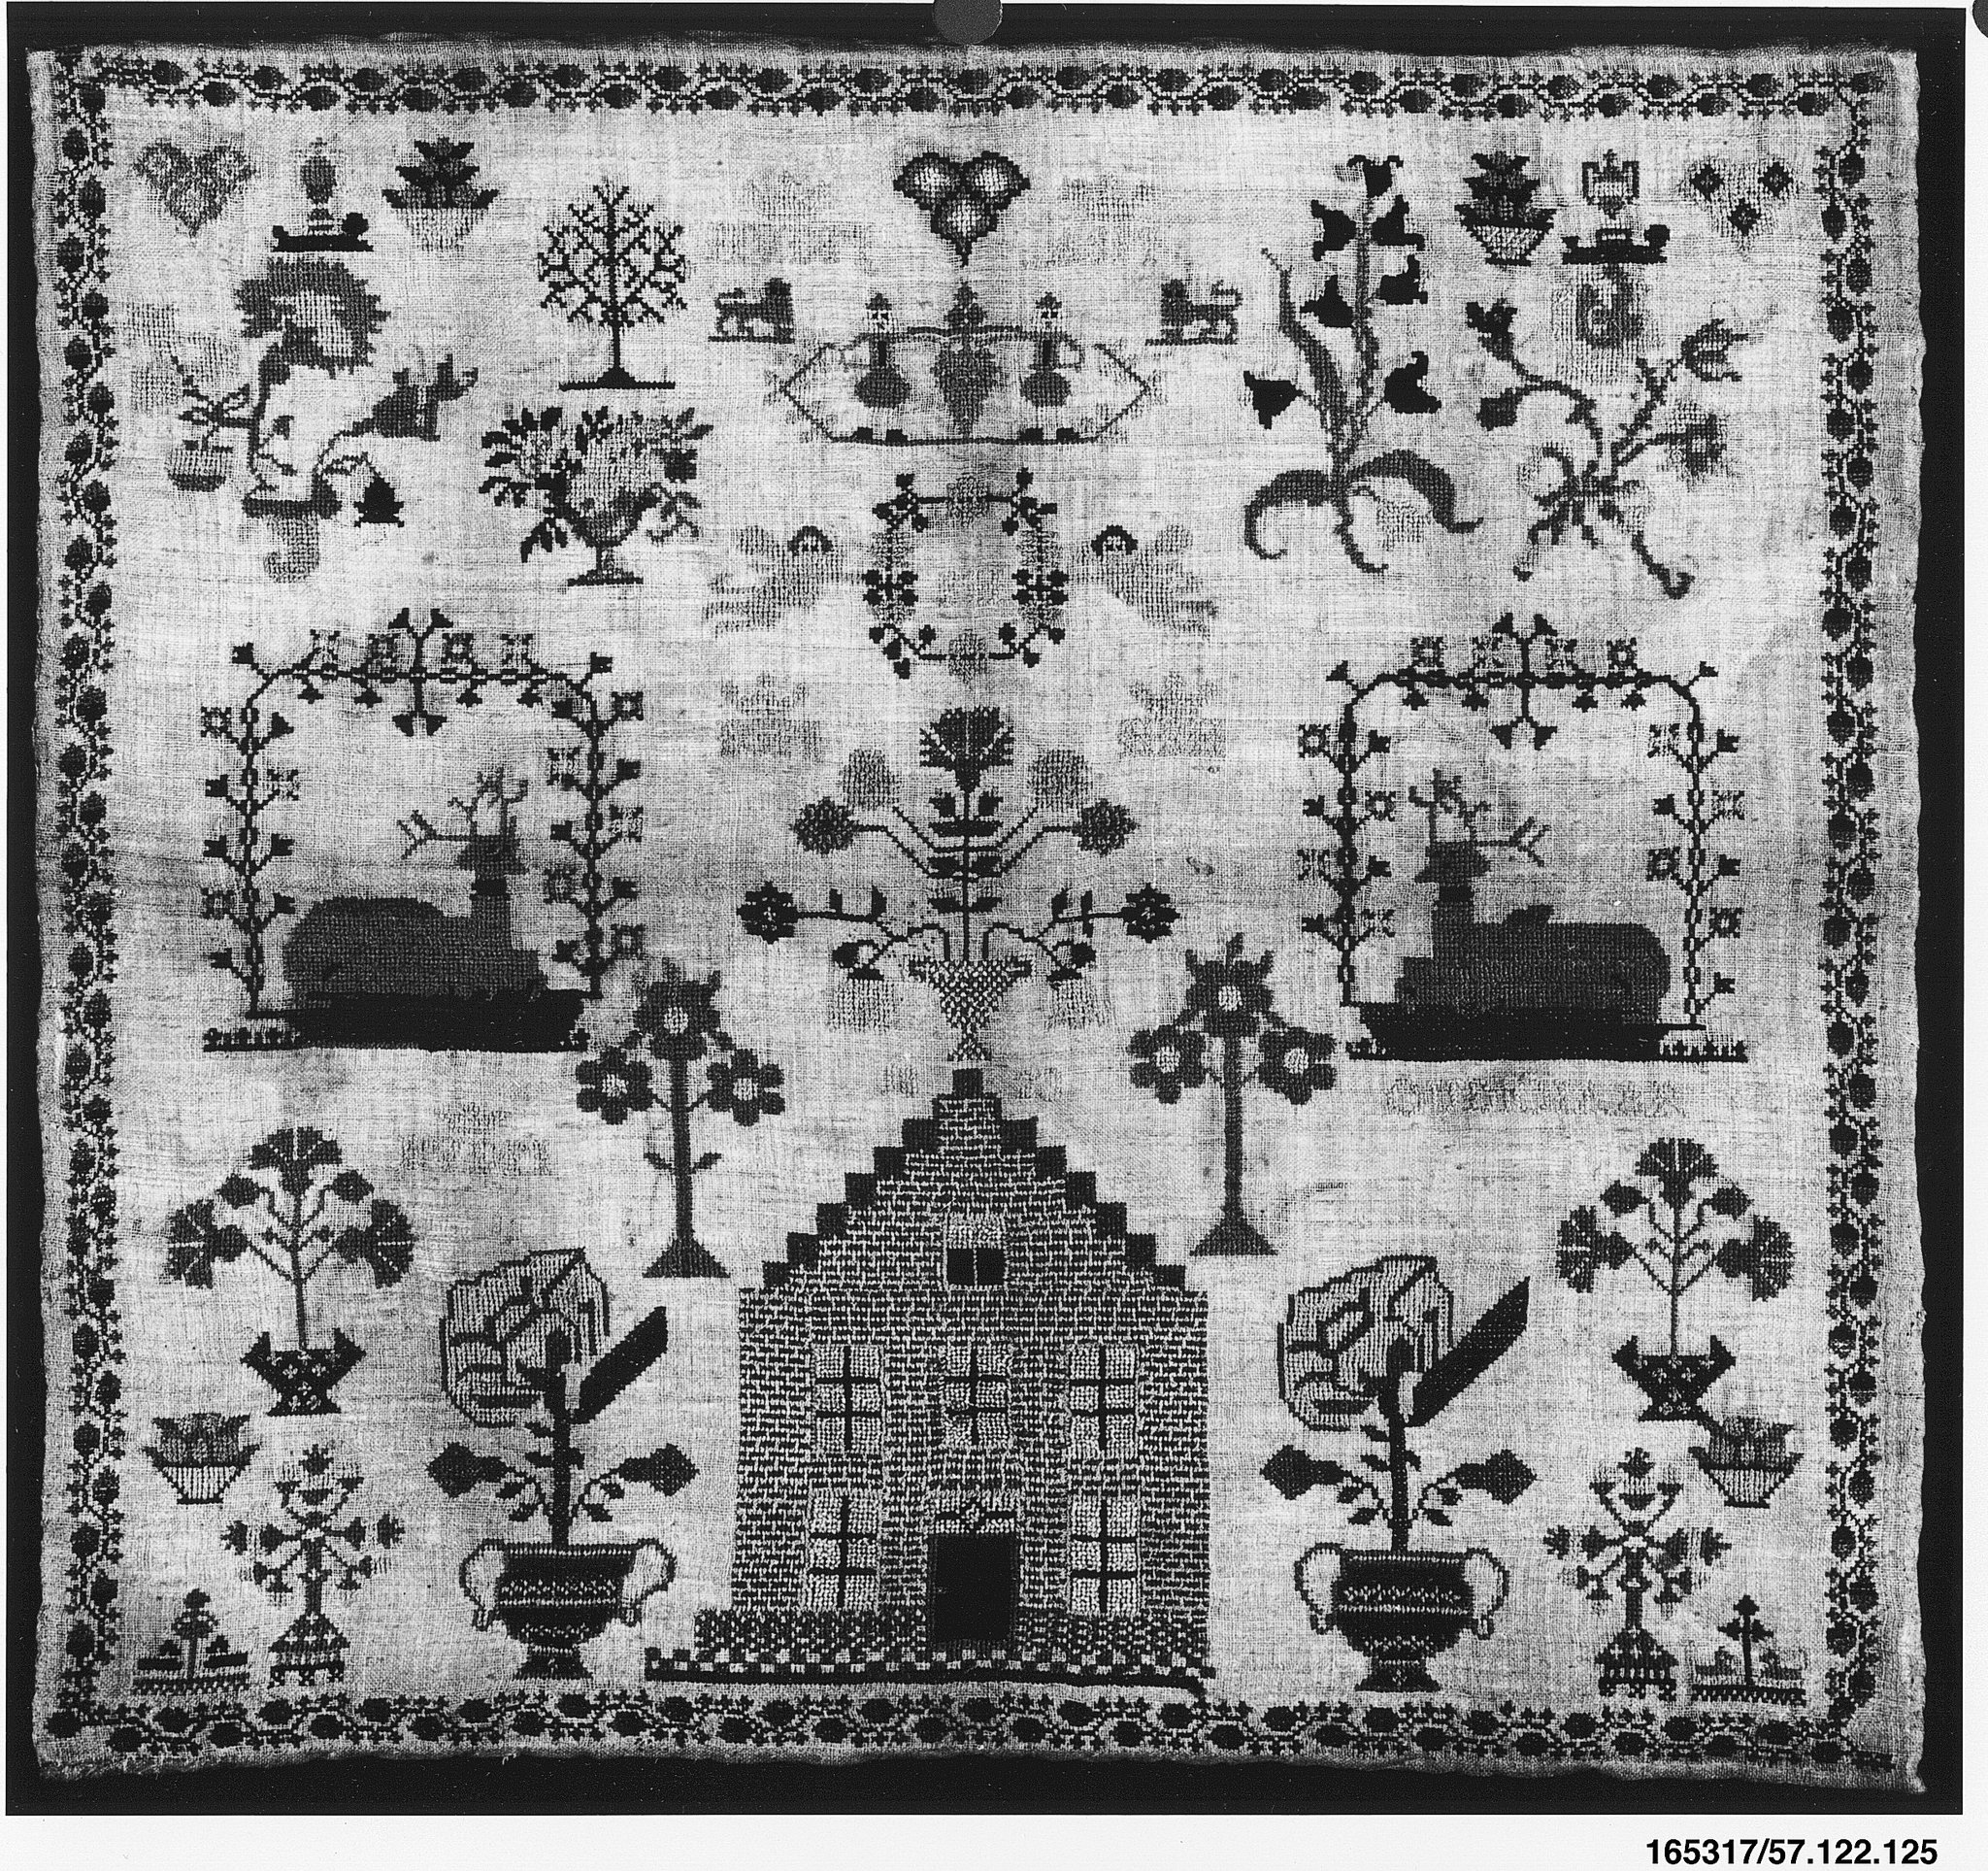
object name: sampler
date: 1823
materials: linen, silk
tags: flowers,leaves